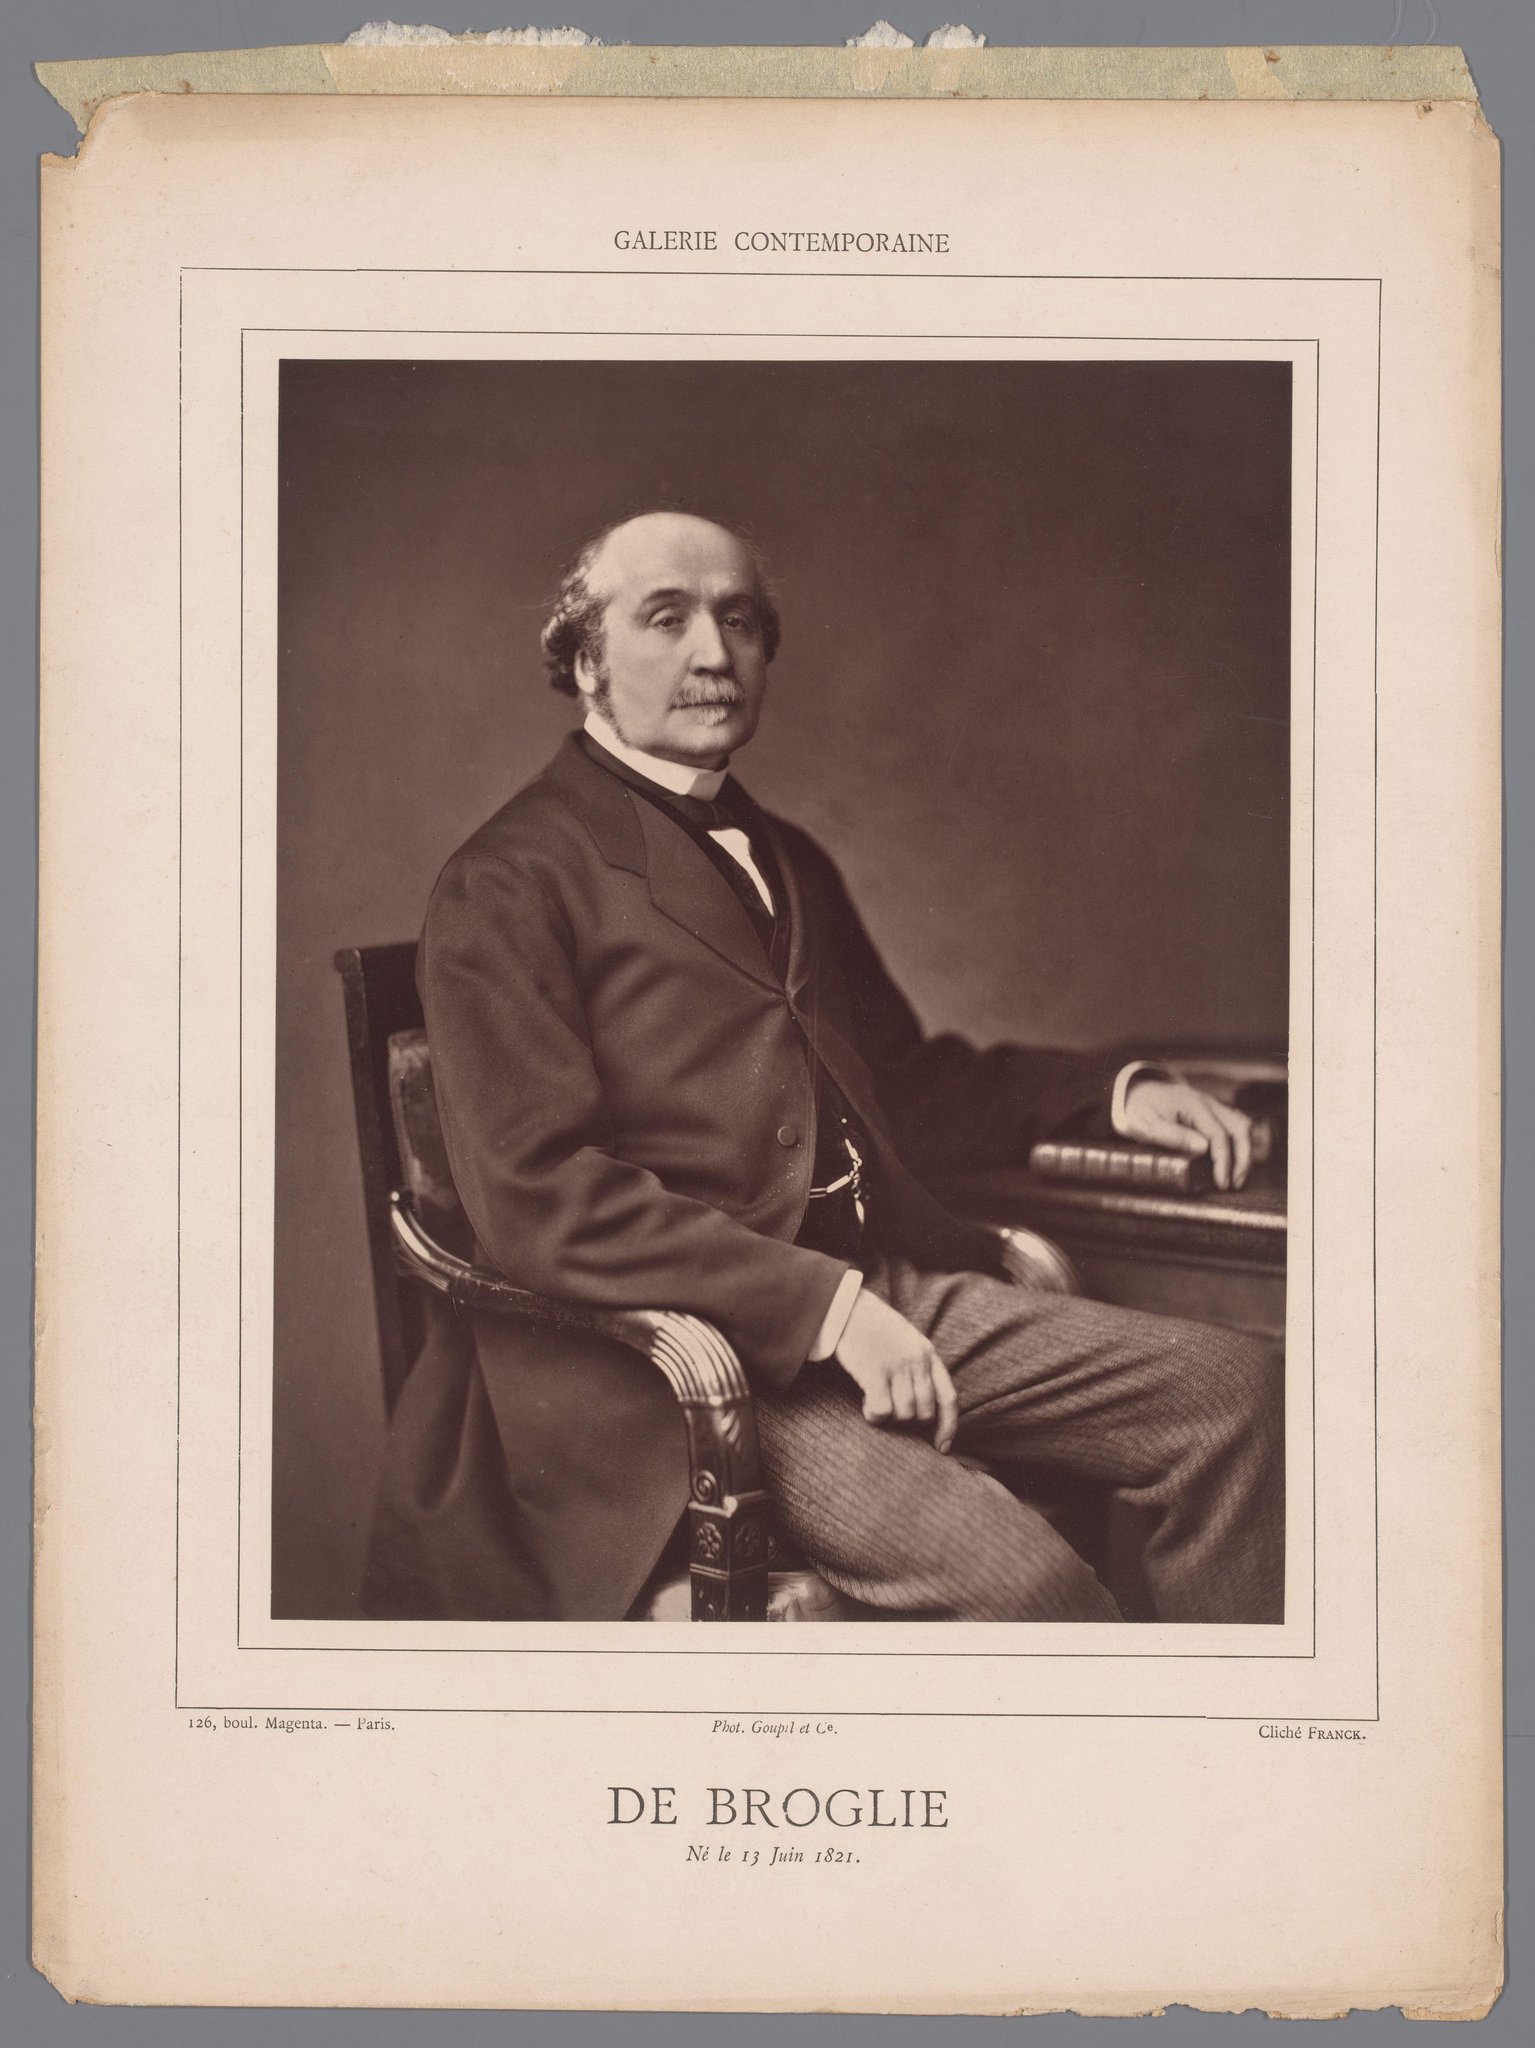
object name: photograph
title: De Broglie. Né le 13 Juin 1821.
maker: françois marie louis franck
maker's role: fotograaf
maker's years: 1816-1906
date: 1876-1884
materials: cardboard, photographic support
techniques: woodburytype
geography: paris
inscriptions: inscription: ‘126, boul. Magenta. - Paris Phot. Goupil et Ce. Cliché FRANCK.’, inscription: ‘DE BROGLIE//Né le 13 juin 1821.’, inscription: ‘GALERIE CONTEMPORAINE’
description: De Fransman Jaques Victor Albert, duc de Broglie (1821-1901) was diplomaat, politicus, historicus en schrijver. Hij zit aan een tafel, zijn linkerarm op de tafel en een boek rustend.